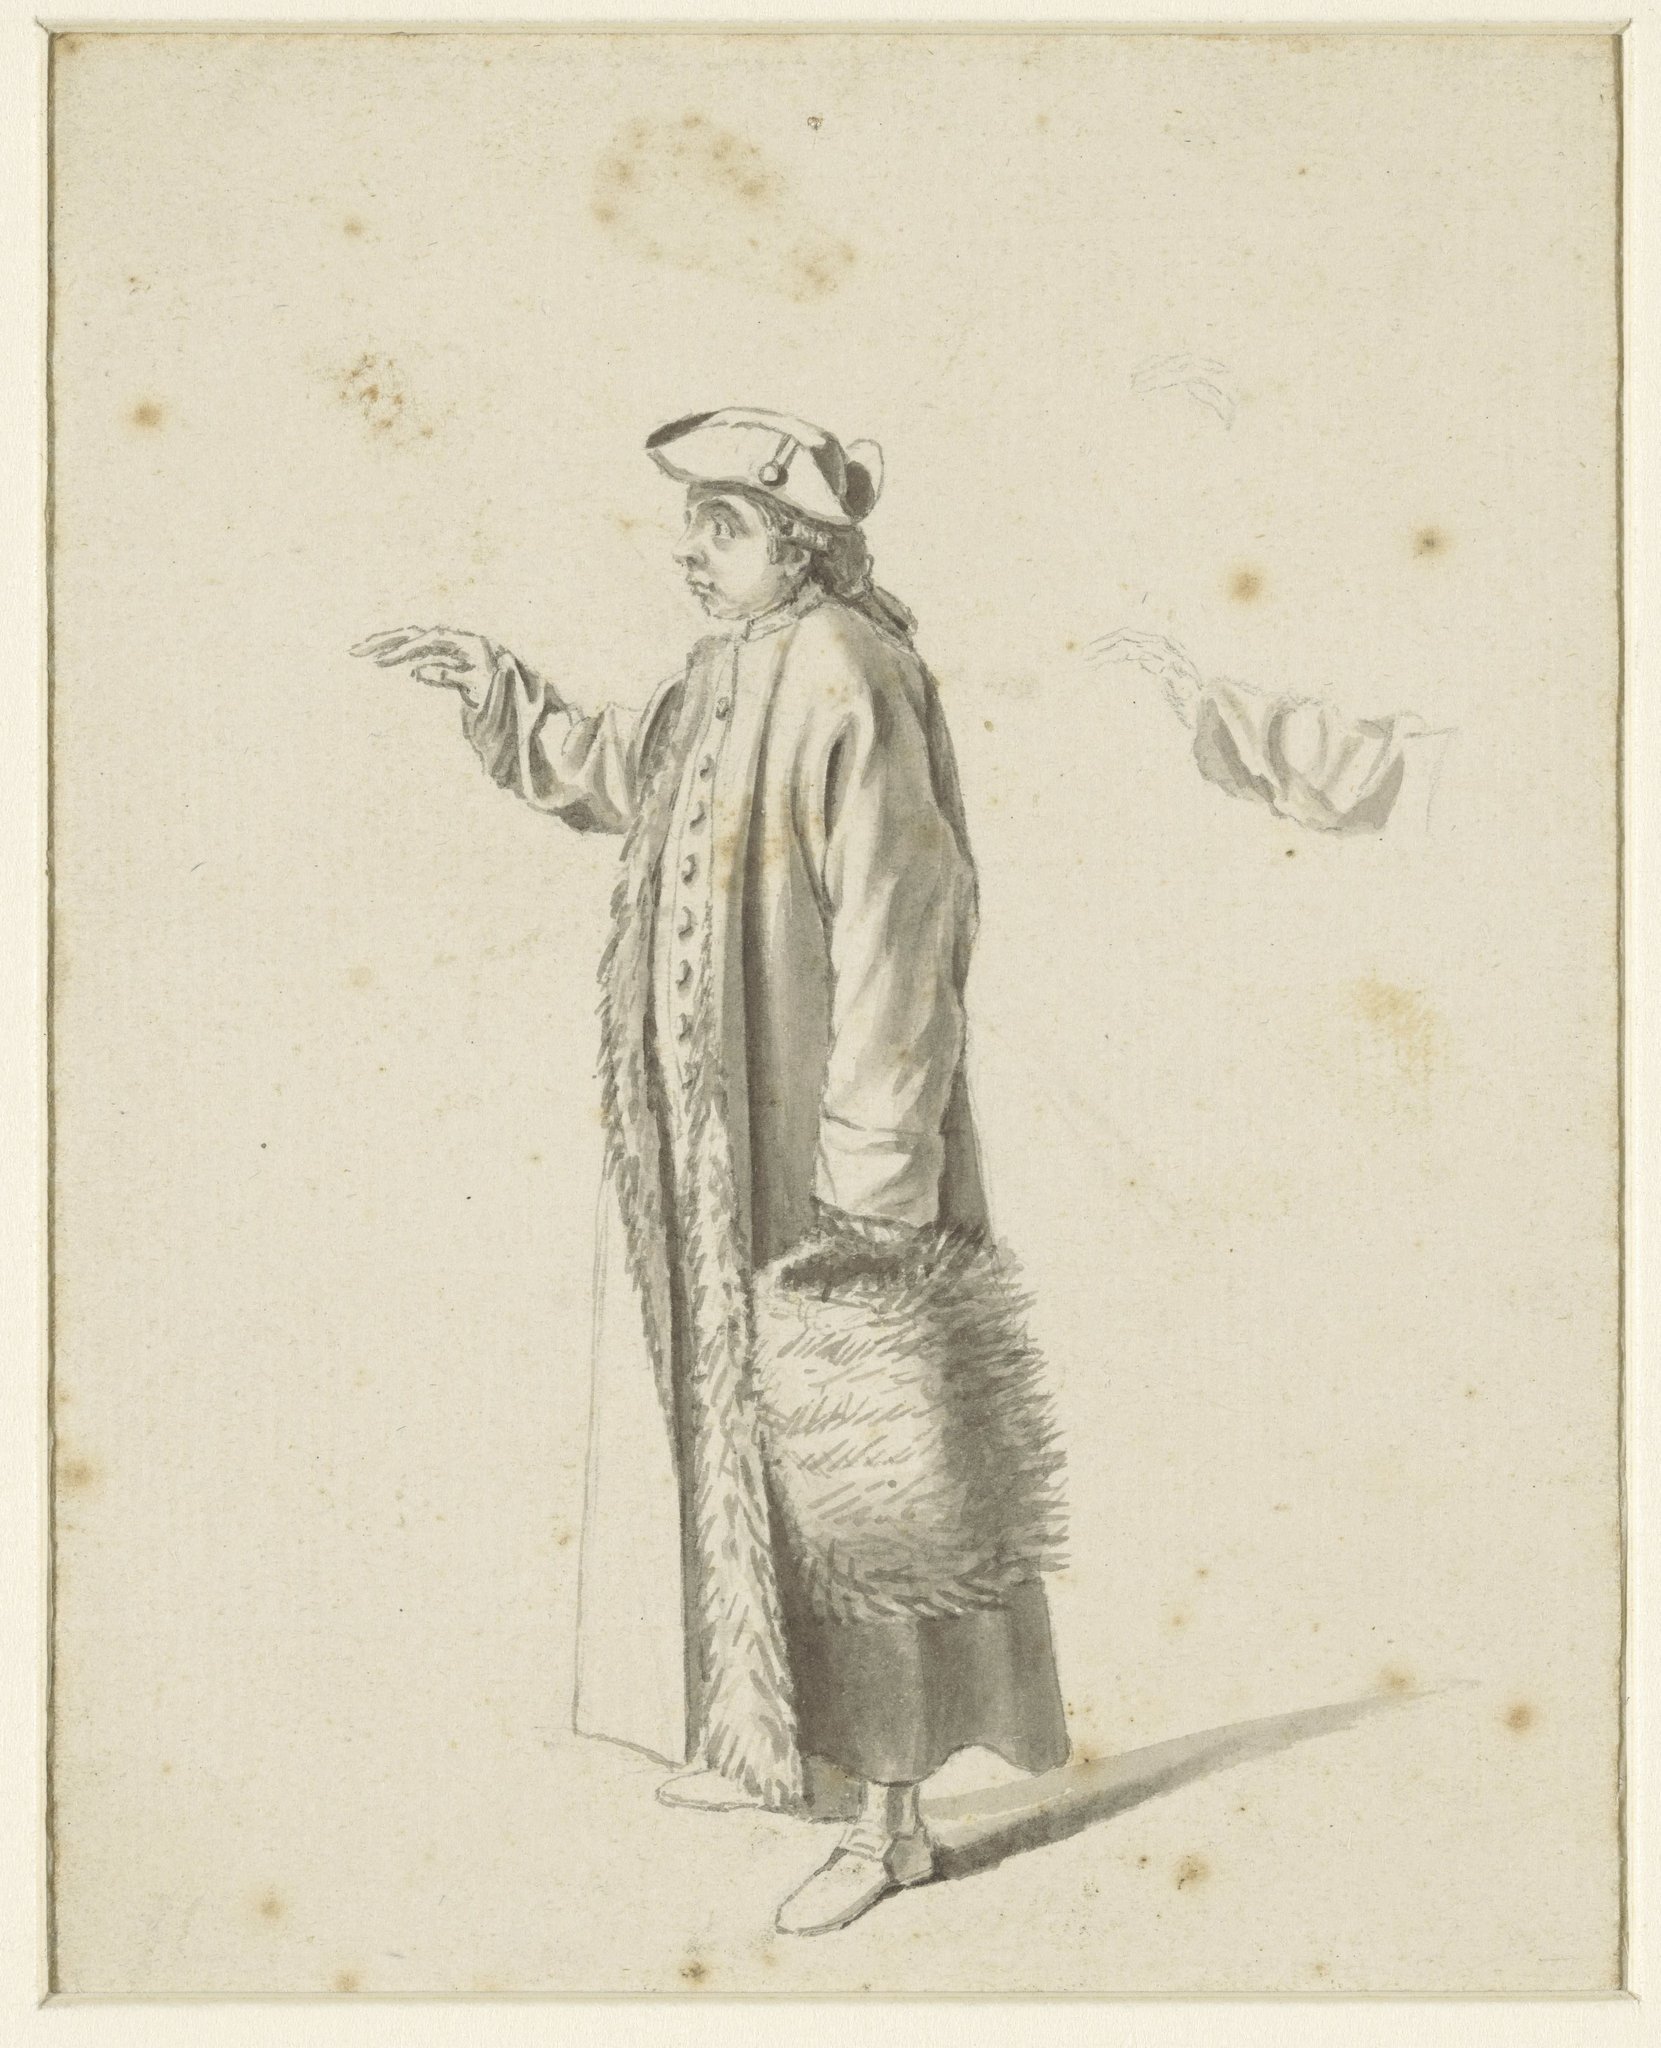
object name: drawing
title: Lopende man met steek op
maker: charles de stoppelaer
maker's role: draughtsman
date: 1703-1738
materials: paper, pencil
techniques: brush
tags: muff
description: Lopende man met steek op, met bont gevoerde mantel en een mof in de linkerhand (de abt der abdij van de Mont Saint-Michel?).